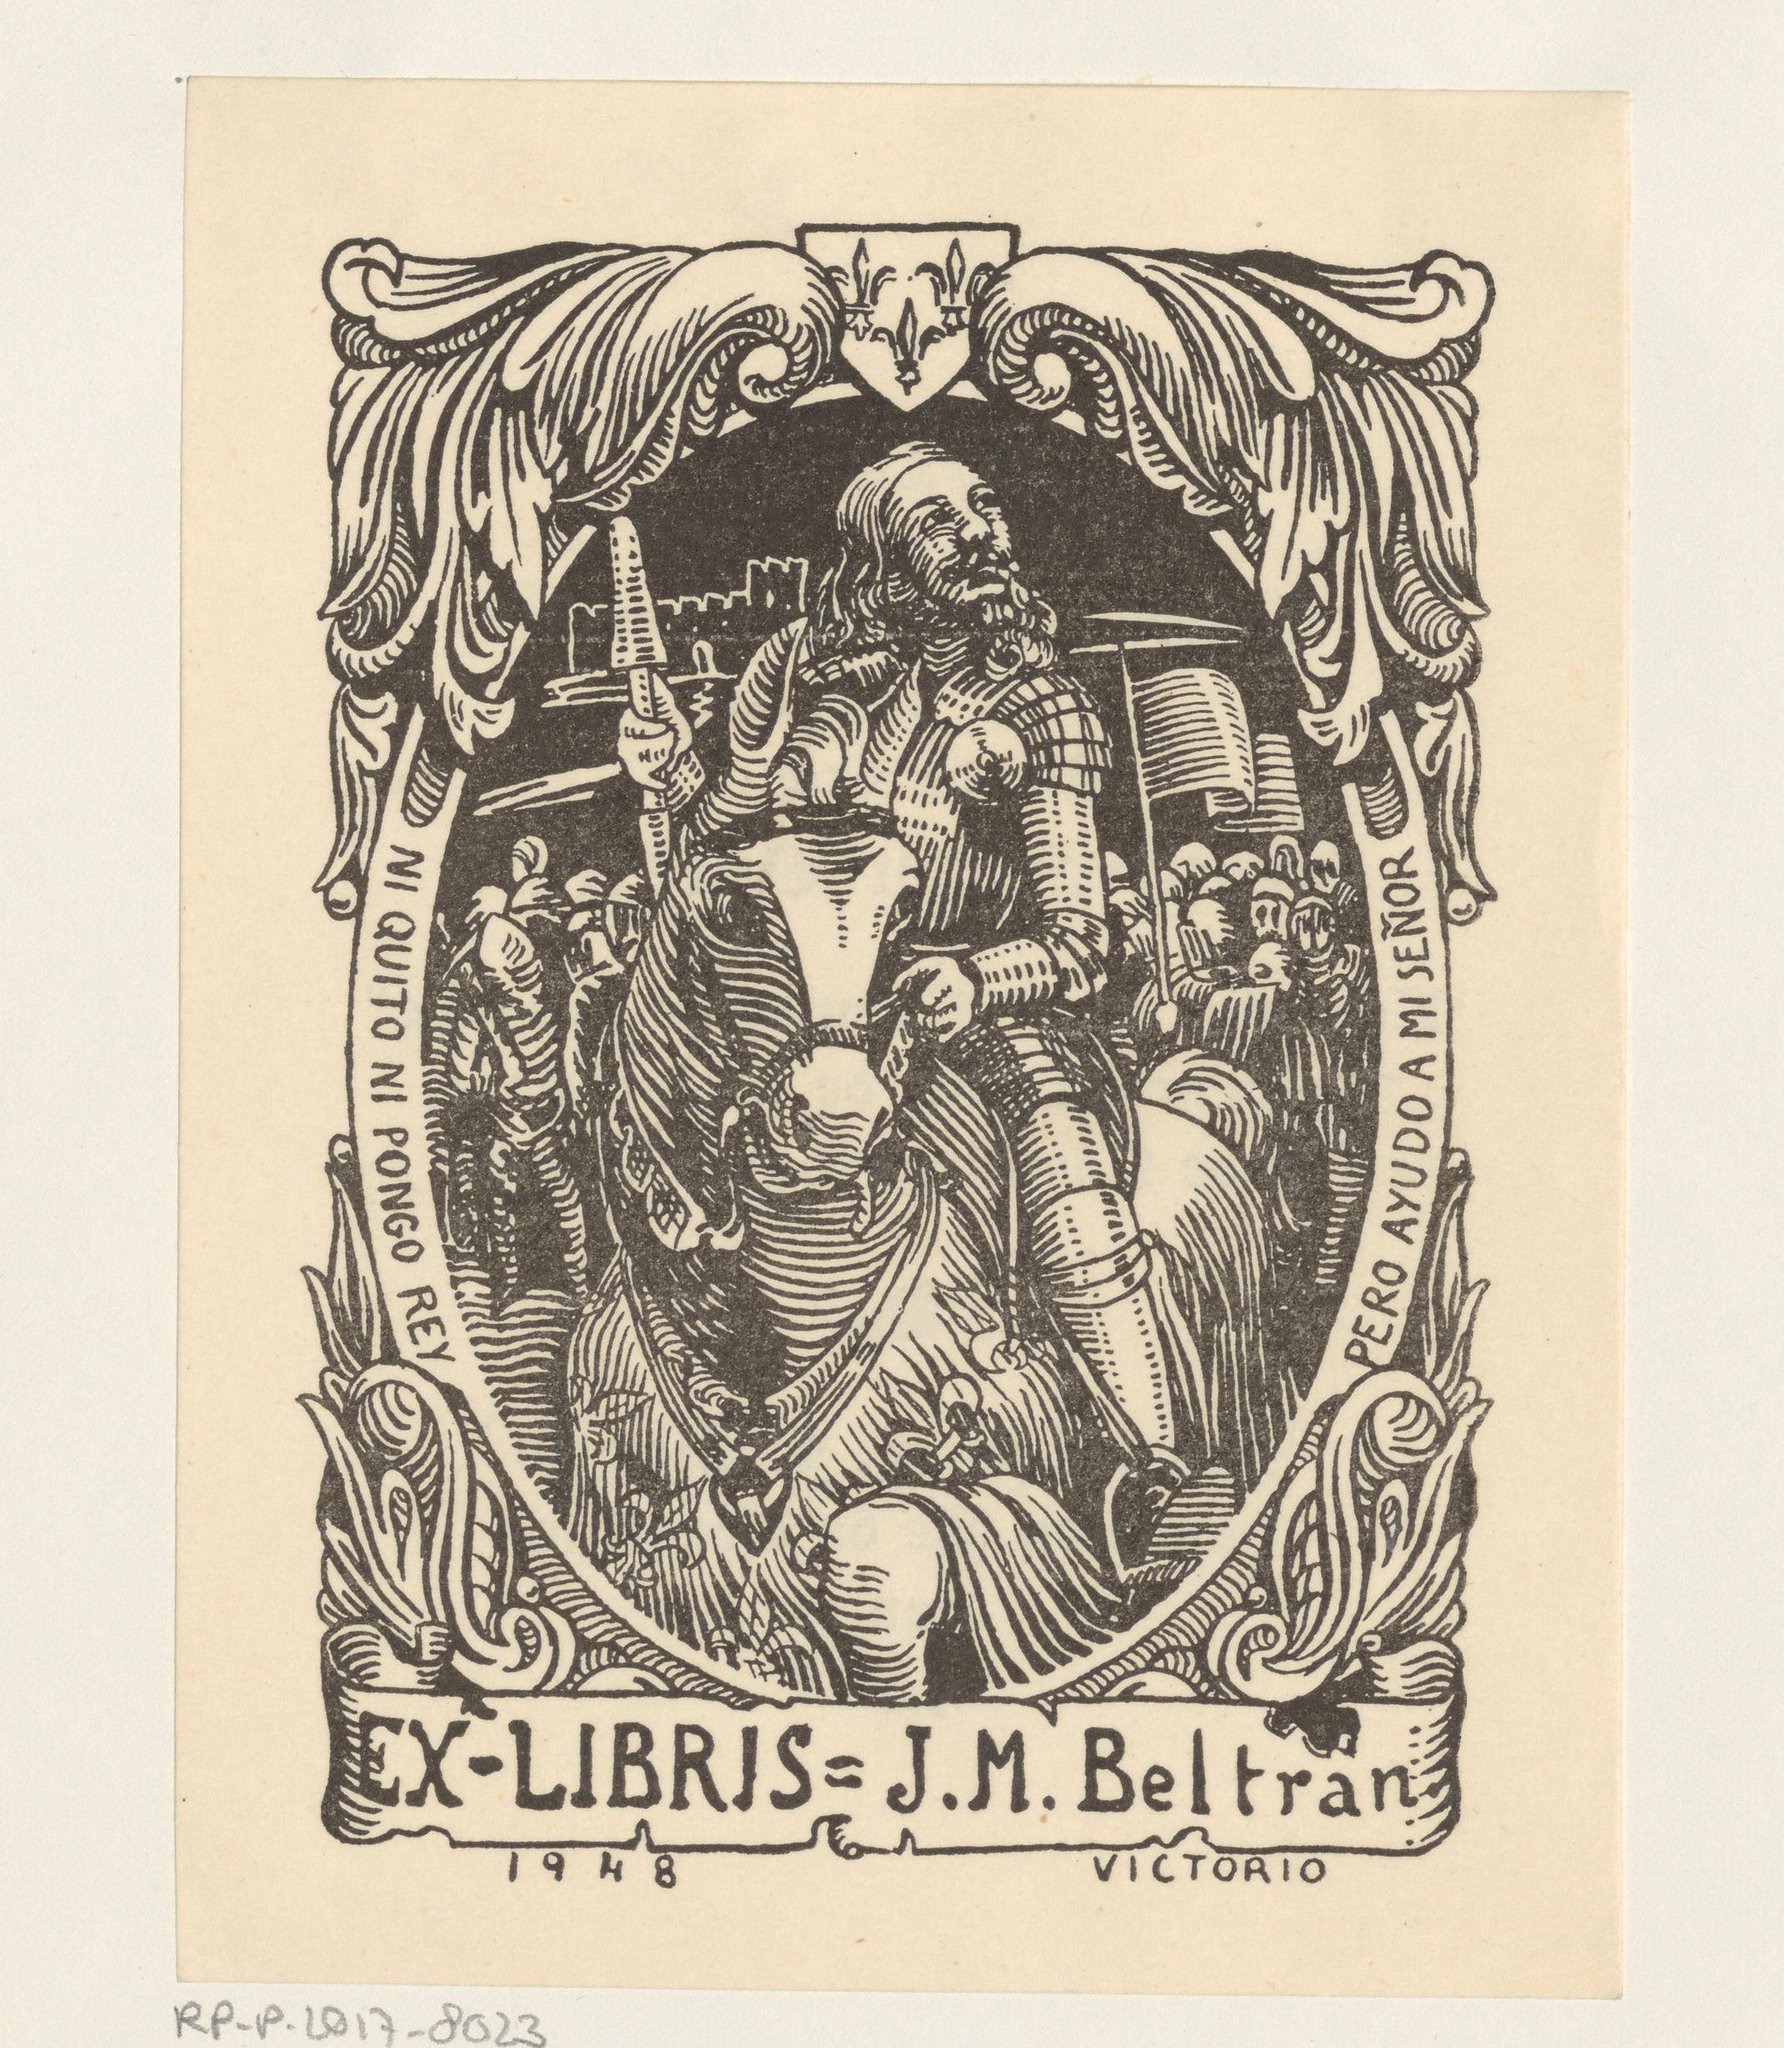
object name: bookplate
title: Ni quito ni pongo rey pero ayudo a mi señor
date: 1948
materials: paper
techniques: printing block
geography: tenerife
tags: horse, knight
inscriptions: inscription: ‘Ex libris/ en/ souvenir de Preux Chevalier/ du/ Roy du France/ Beltran du Guesclin (...) Dessiné par F.F. Victorio/ dans son île de Ténerife/ en 1948’, stamp: ‘Italia [...]/ Valladolid’